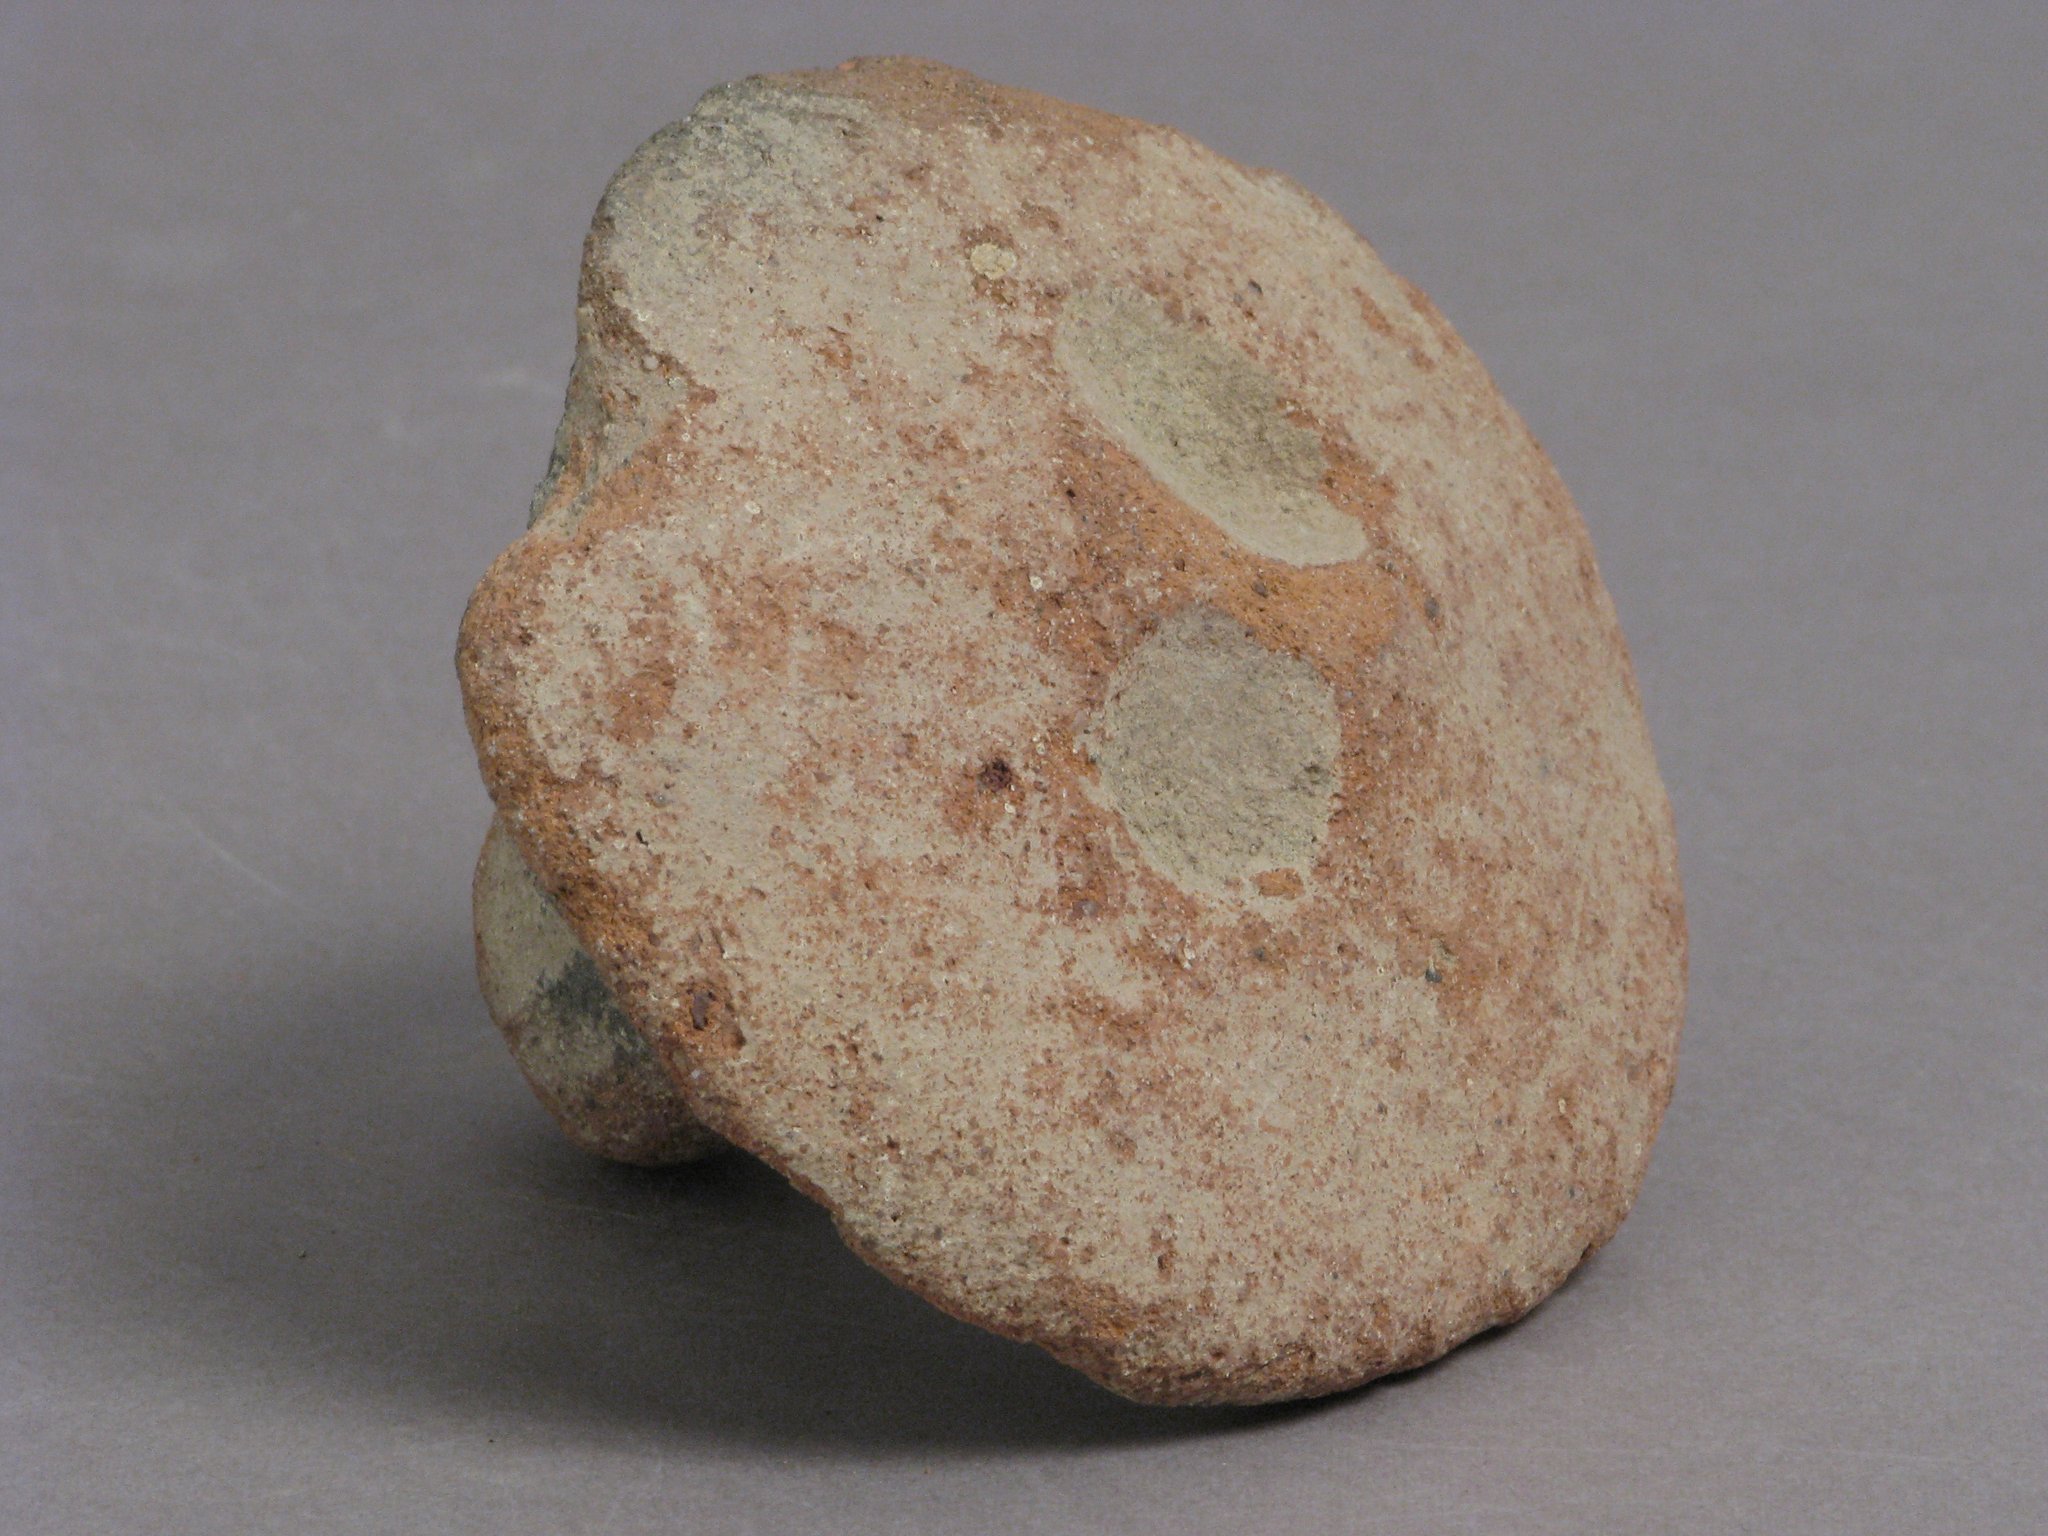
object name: lid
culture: coptic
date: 301-700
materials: earthenware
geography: egypt